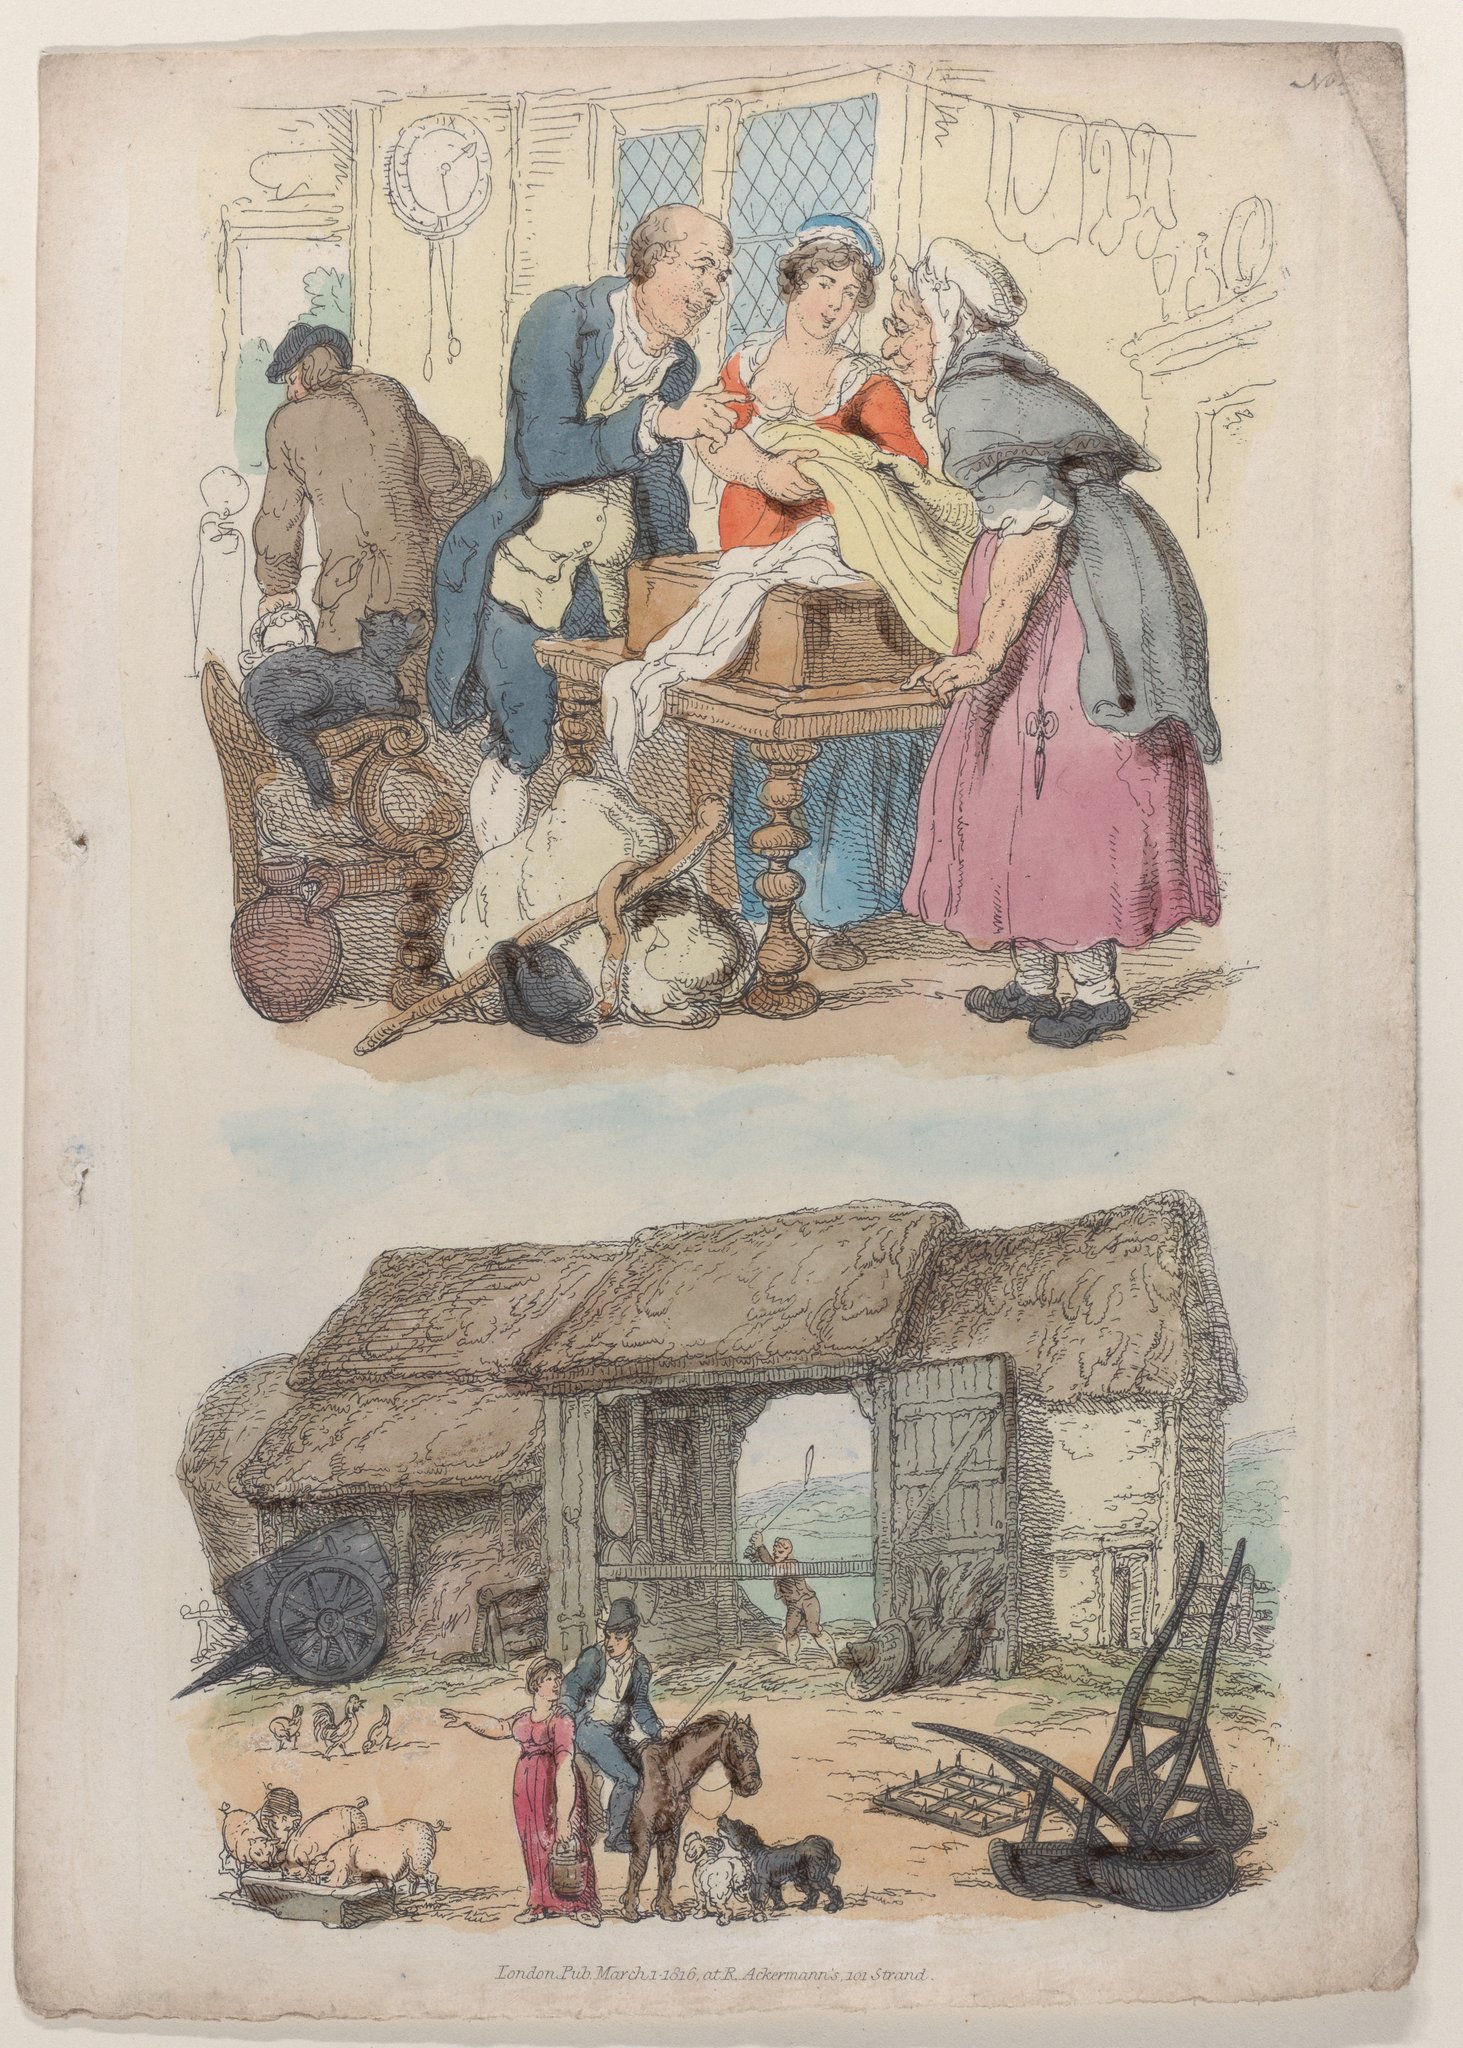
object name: print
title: Plate 5, from "World in Miniature"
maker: thomas rowlandson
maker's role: artist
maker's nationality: british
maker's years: 1757-1827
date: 1816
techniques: etching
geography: london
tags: farms,men,women,dogs,horses